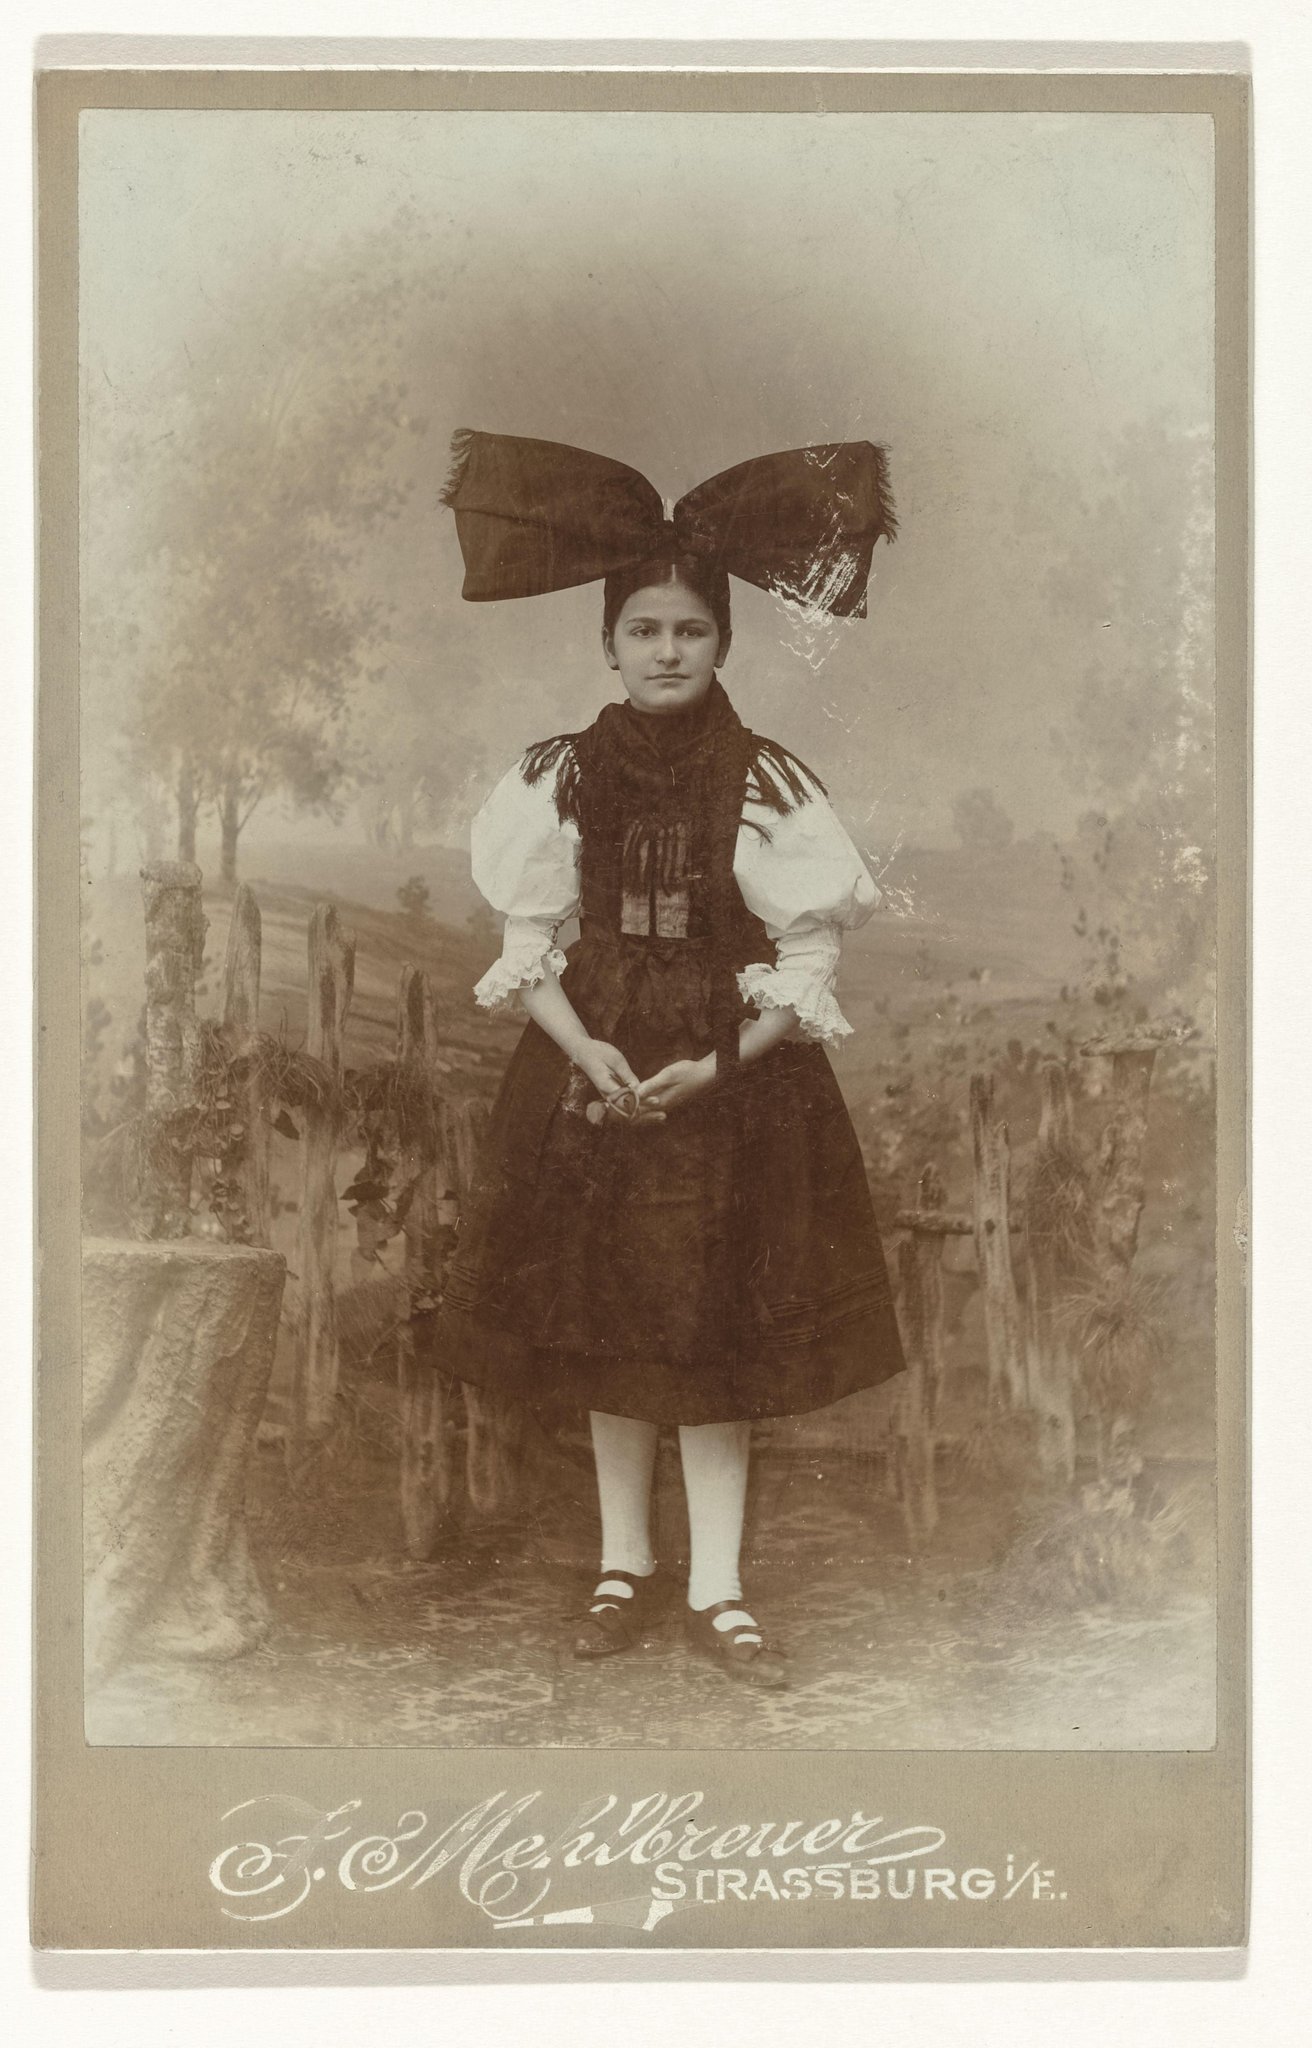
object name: photograph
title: Mathilde Wachenheimer-Wertheimer als jonge vrouw met een enorme strik in het haar, voor een geschilderde landelijke achtergrond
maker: johann mehlbreuer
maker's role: fotograaf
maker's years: 1844-1914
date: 1875-1885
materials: photographic support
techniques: gelatin silver print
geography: straatsburg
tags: mathilde wachenheimer-wertheimer, stuttgart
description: Mathilde Wachenheimer-Wertheimer als jonge vrouw in een donkere jurk met lichte mouwen en grote strik in het haar, voor een geschilderde landelijke achtergrond.